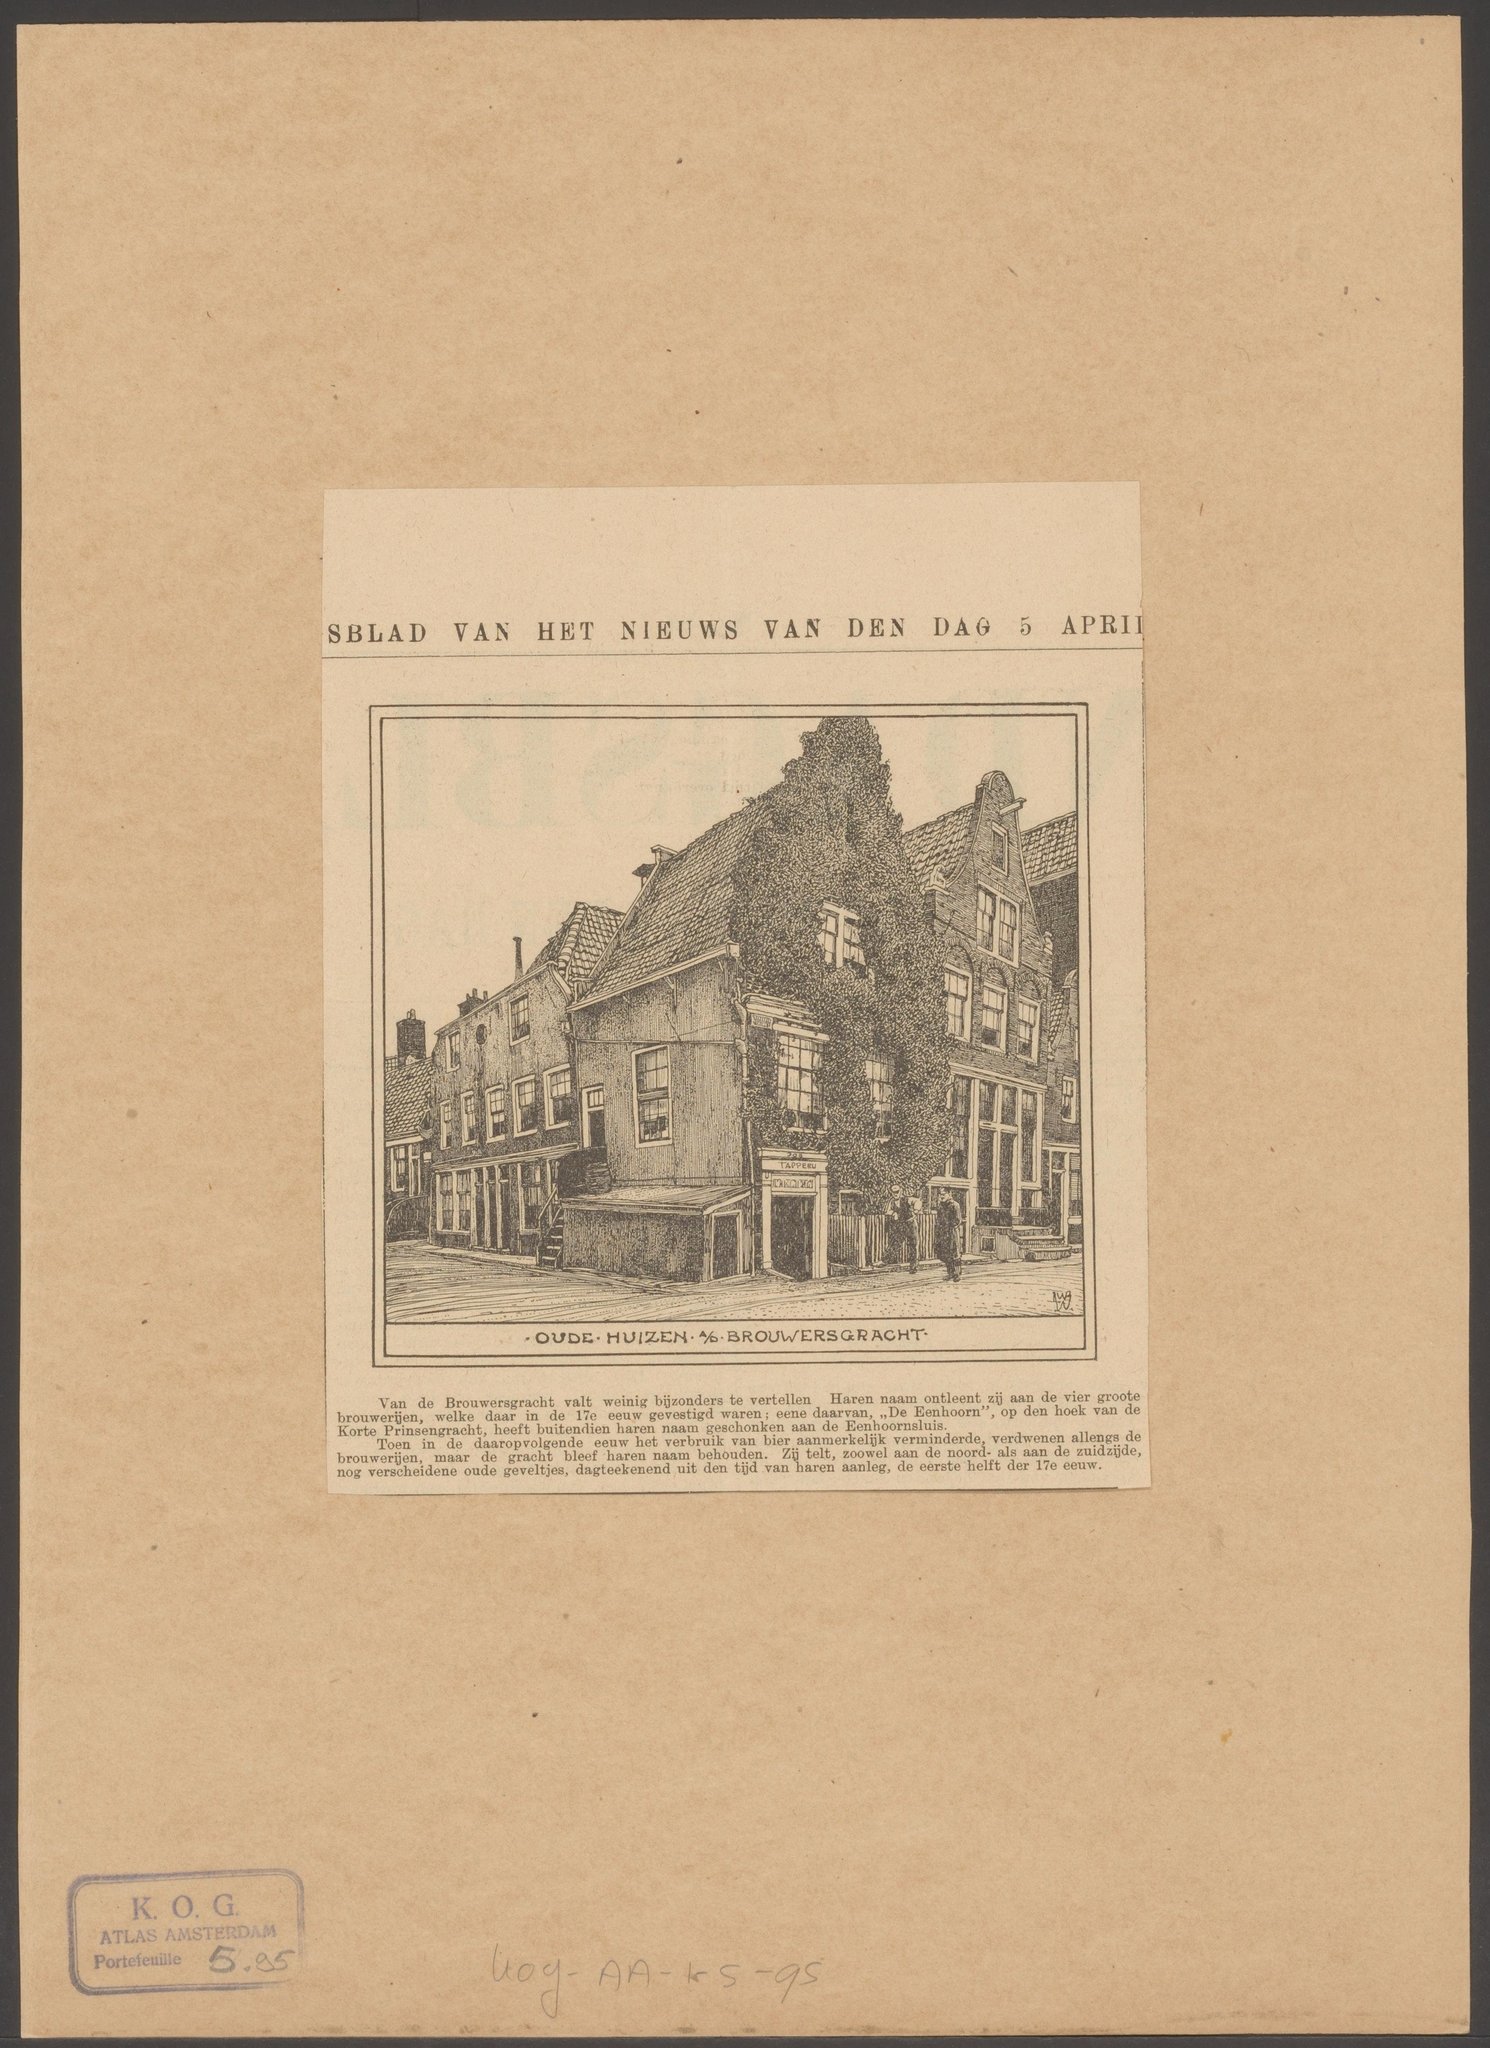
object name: photomechanical print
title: Gezicht op enkele huizen aan de Brouwersgracht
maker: willem wenckebach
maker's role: designer, draughtsman, painter, print maker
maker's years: 1860-1937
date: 1870-1923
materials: paper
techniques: letterpress printing, line block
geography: amsterdam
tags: city-view in general; 'veduta', the usual house or row of houses, façade (of house or building), street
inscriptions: collector's mark: ‘5.95’ Lugt 1641b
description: Onderwerpsrubriek binnen de Atlas Amsterdam: Begijnensloot (Gedempte), Bagijnhofsteeg, Beulingsloot, Bickersgracht en –plein, Bickersstraat (Groote), Bilderdijkskade en -straat, Binnenkant, Blauwburgwal, Boomdwarsstraat, Brouwersgracht, Bleekersspad (Lange), Bleekerssloot, Bloemgracht, Boerenwetering, Boltensgrachtje, Boomssloot (Recht), Badhuisweg.